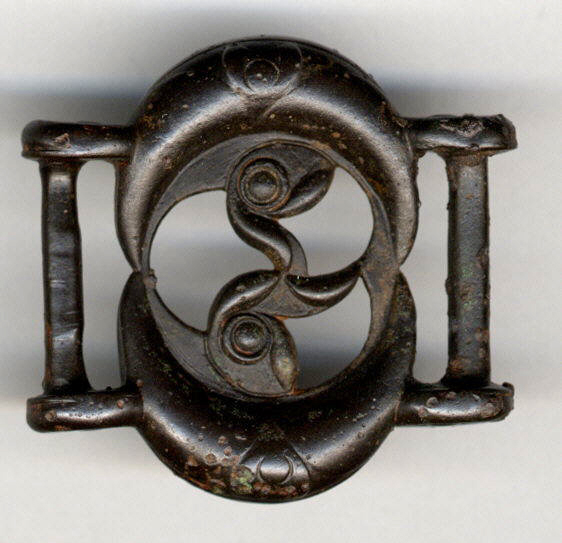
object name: strap attachment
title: Attachment for a Strap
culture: celtic or roman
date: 100-300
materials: copper alloy